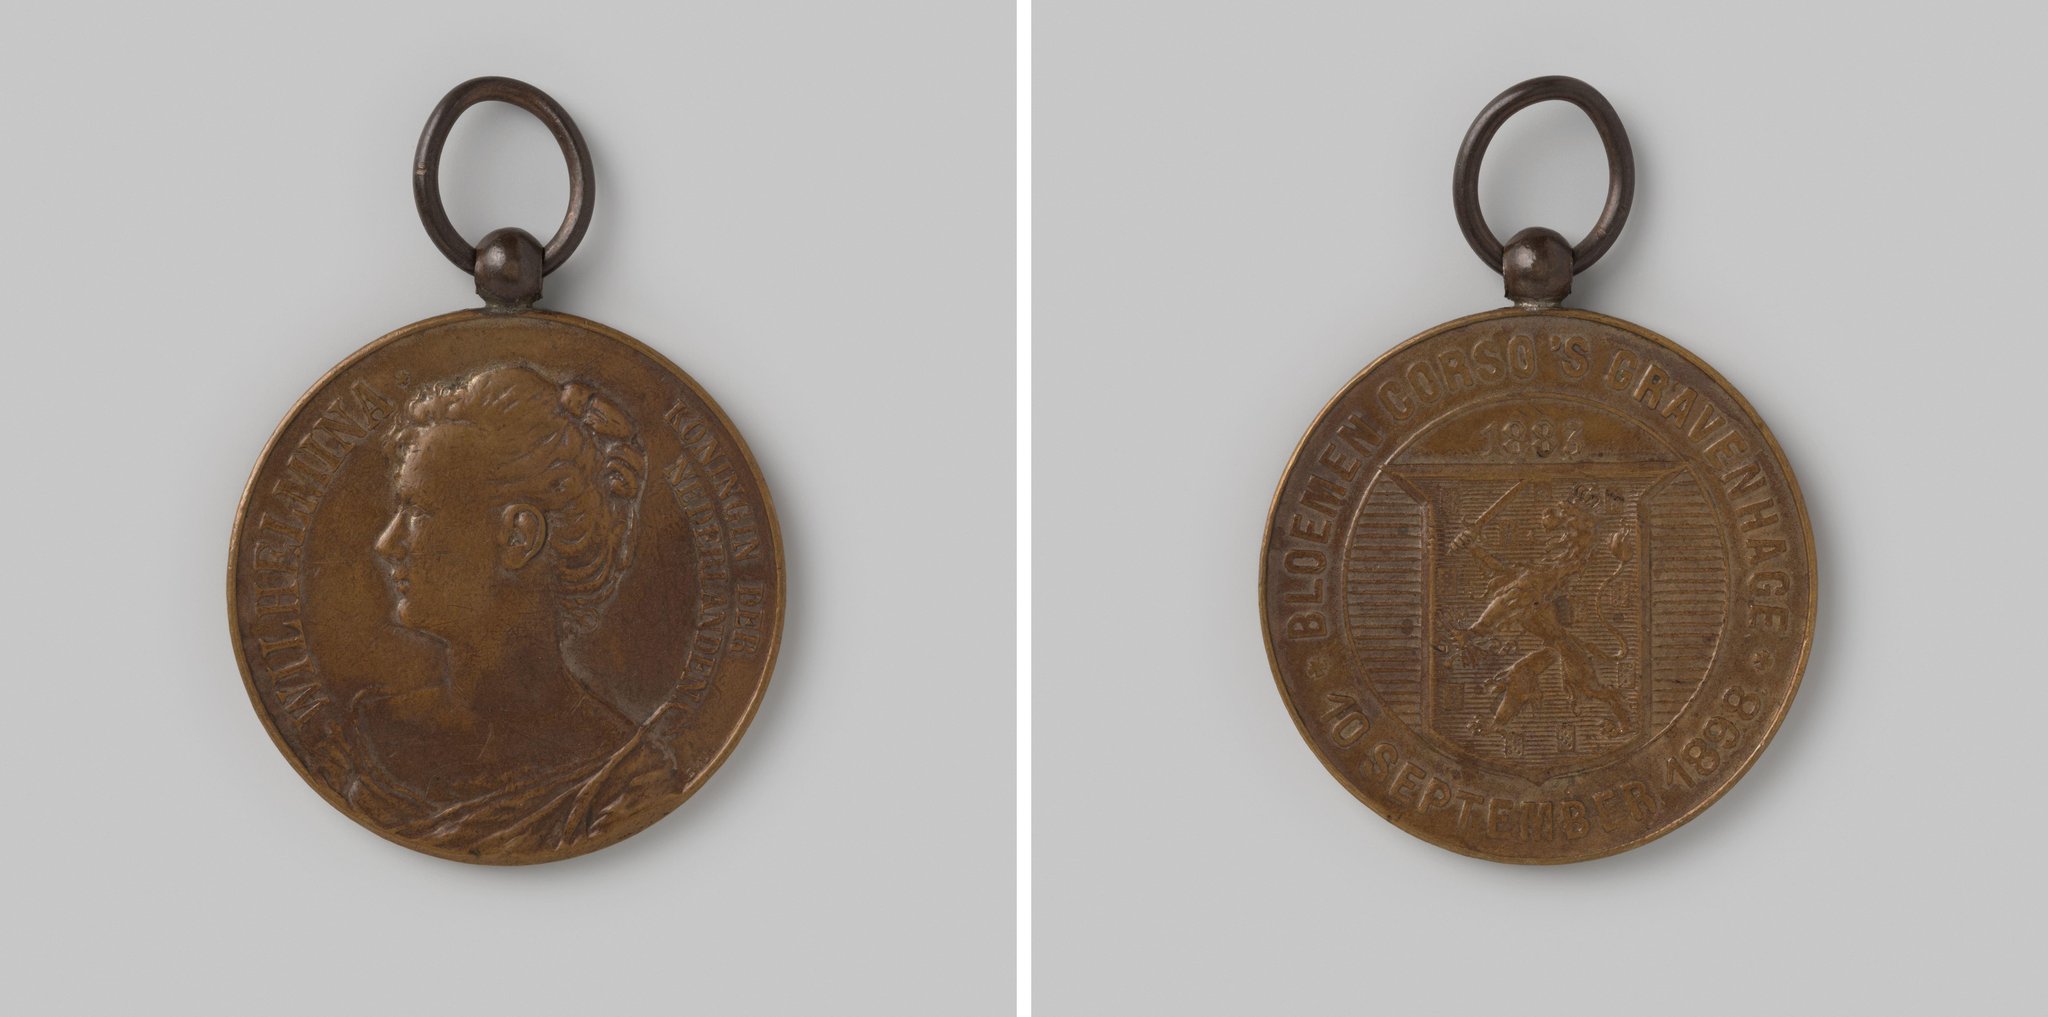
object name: medal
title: Bloemencorso te 's-Gravenhage, georganiseerd door de ANWB ter viering van de inhuldiging van Koningin Wilhelmina 1898, draagpenning voor deelnemers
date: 1898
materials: brass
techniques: striking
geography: utrecht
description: Messing penning met bal en draagoog, op de voorzijde het borstbeeld van Wilhelmina naar links met omschrift, op de keerzijde het Nederlandse wapenschild onder het jaartal 1883, met omschrift.